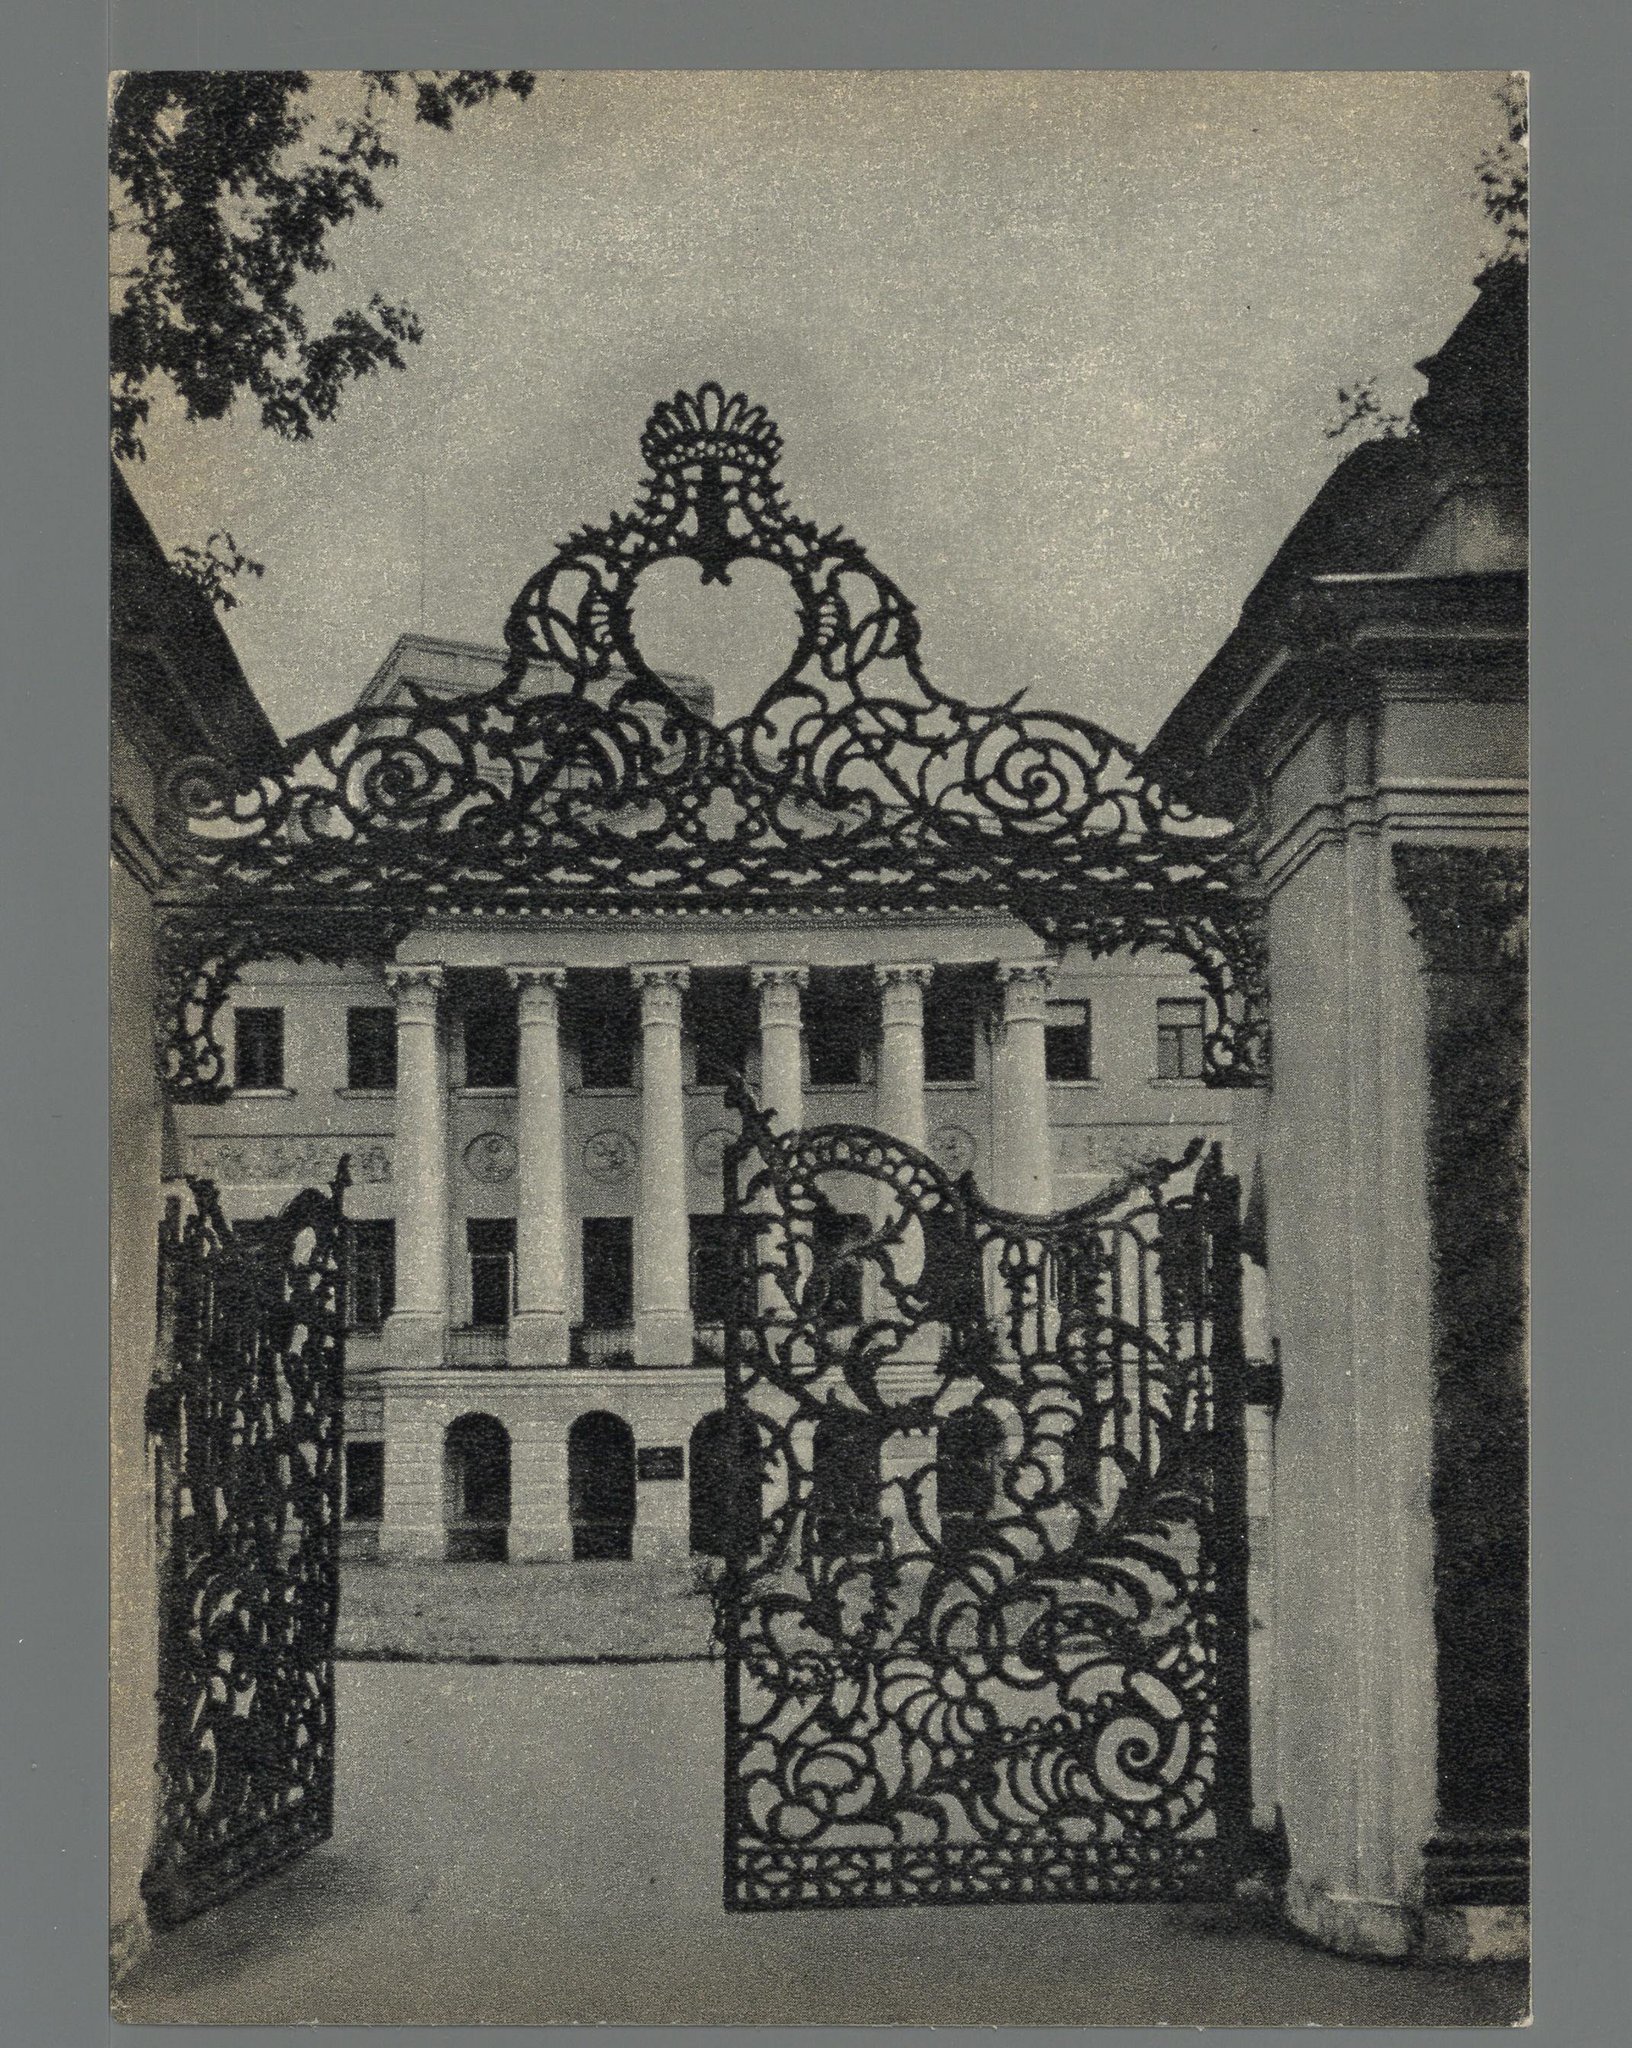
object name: photomechanical print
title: Gezicht op het landhuis van Demidov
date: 1957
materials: cardboard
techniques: rotogravure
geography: moscow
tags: rural housing, e.g. country-house, villa, cottage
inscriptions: date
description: De titel op object staat in het Russisch.